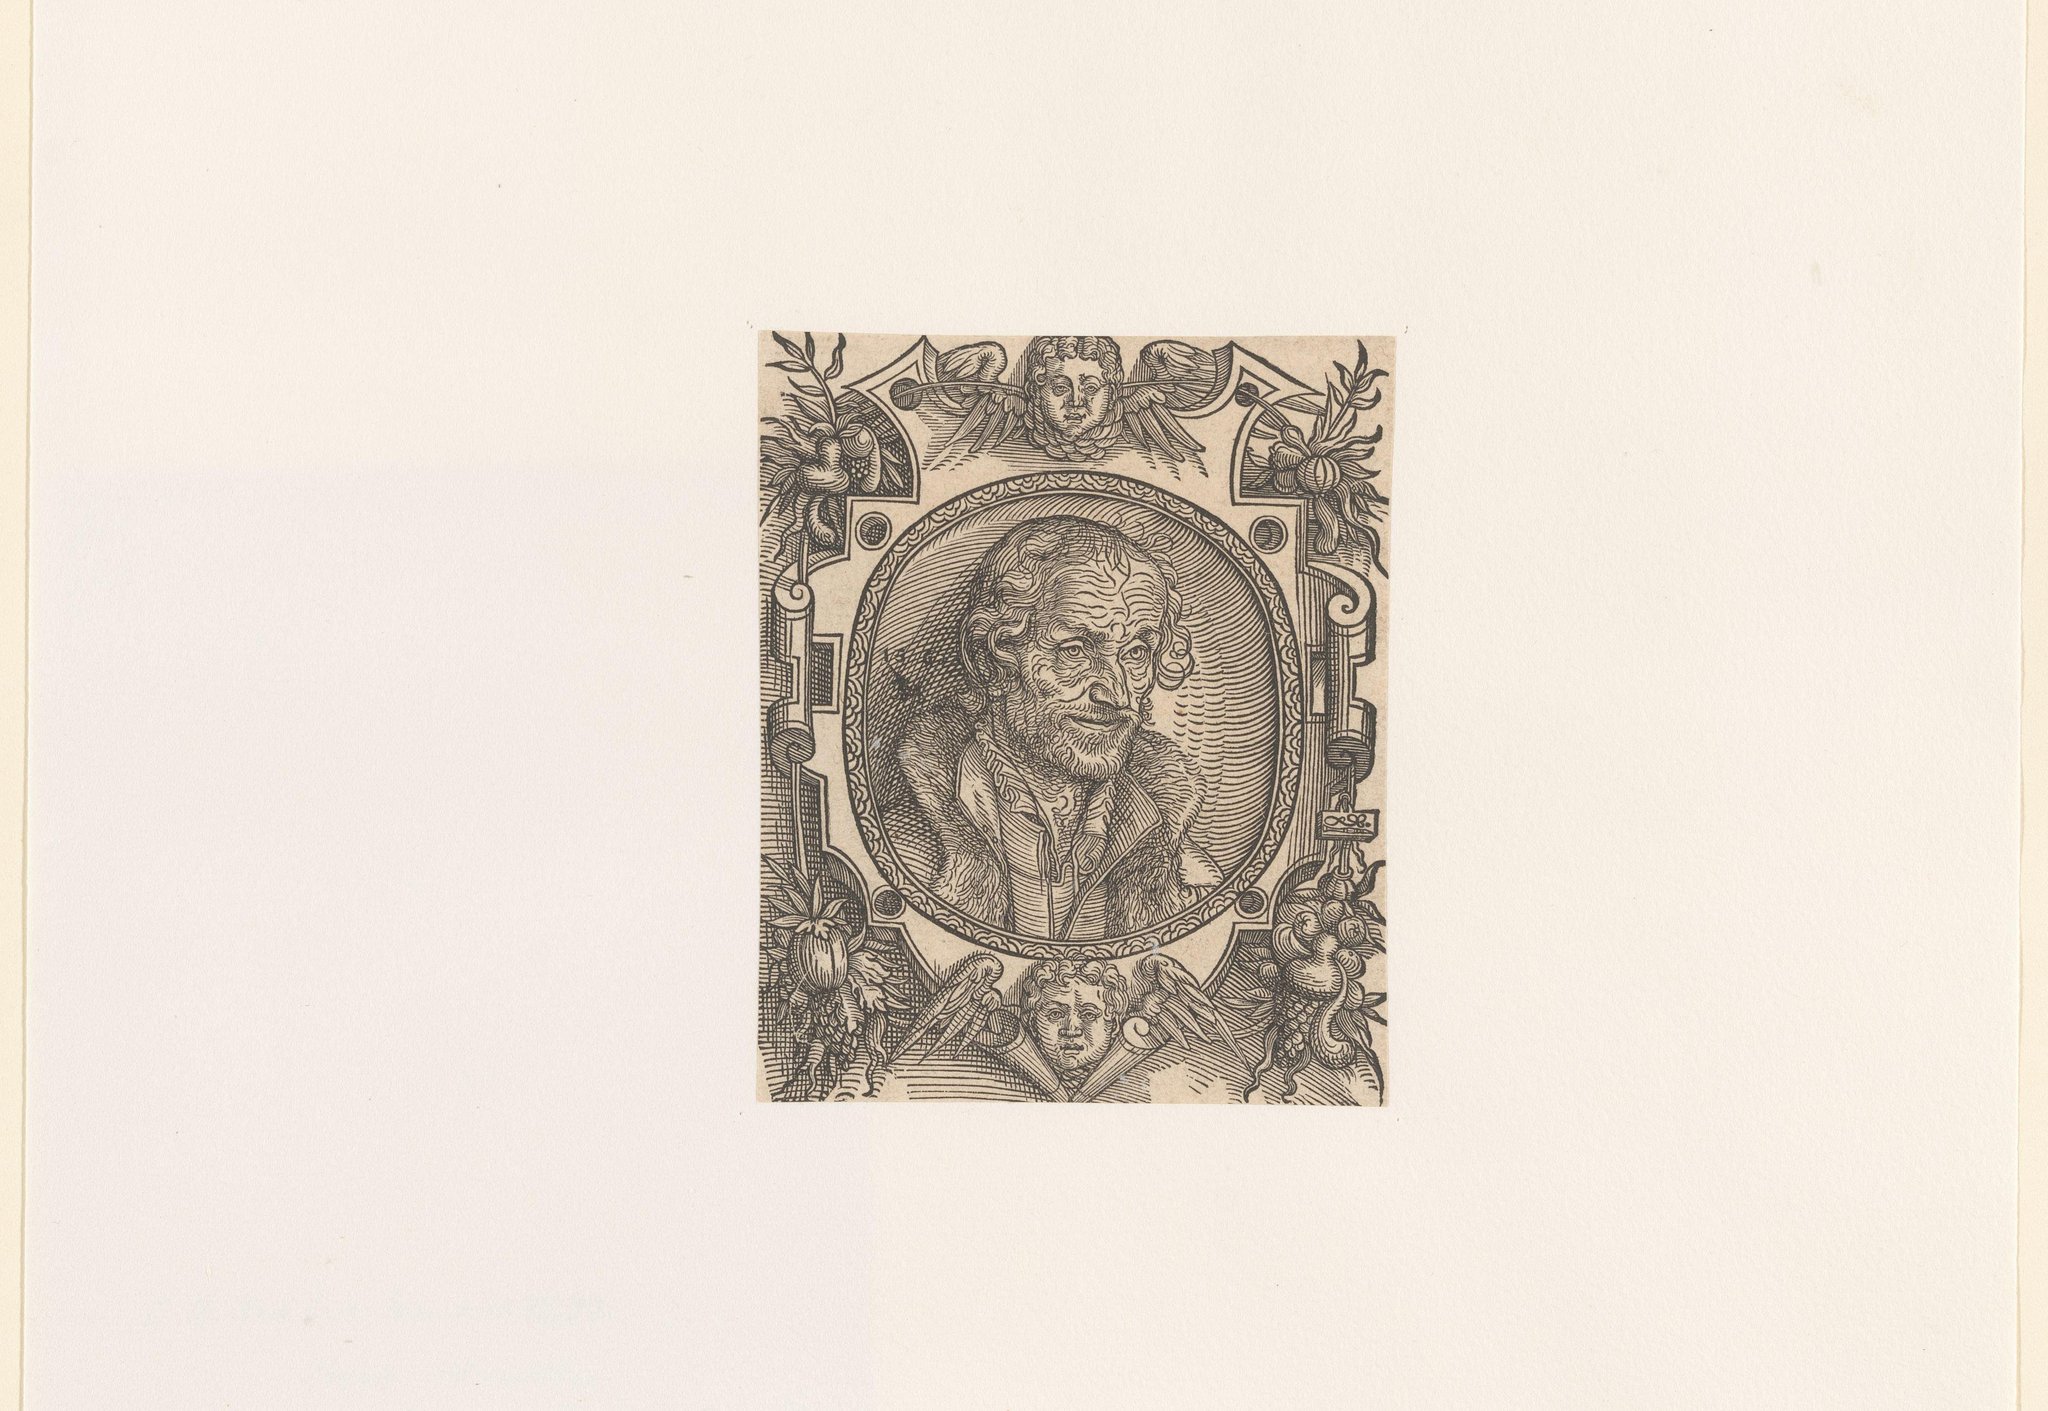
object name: print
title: Portret van Philipp Melanchton in een ornamentale omlijsting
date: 1572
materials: paper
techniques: woodcut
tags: cherubs, i.e. children's heads with wings, fruits and vegetables ~ ornament, historical persons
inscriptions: collector's mark: Lugt 2228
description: Prent ook gebruikt in: Melanchthon, Philipp. Chronicon Carionis (...). Wittenberg: Johannes Crato, 1572.